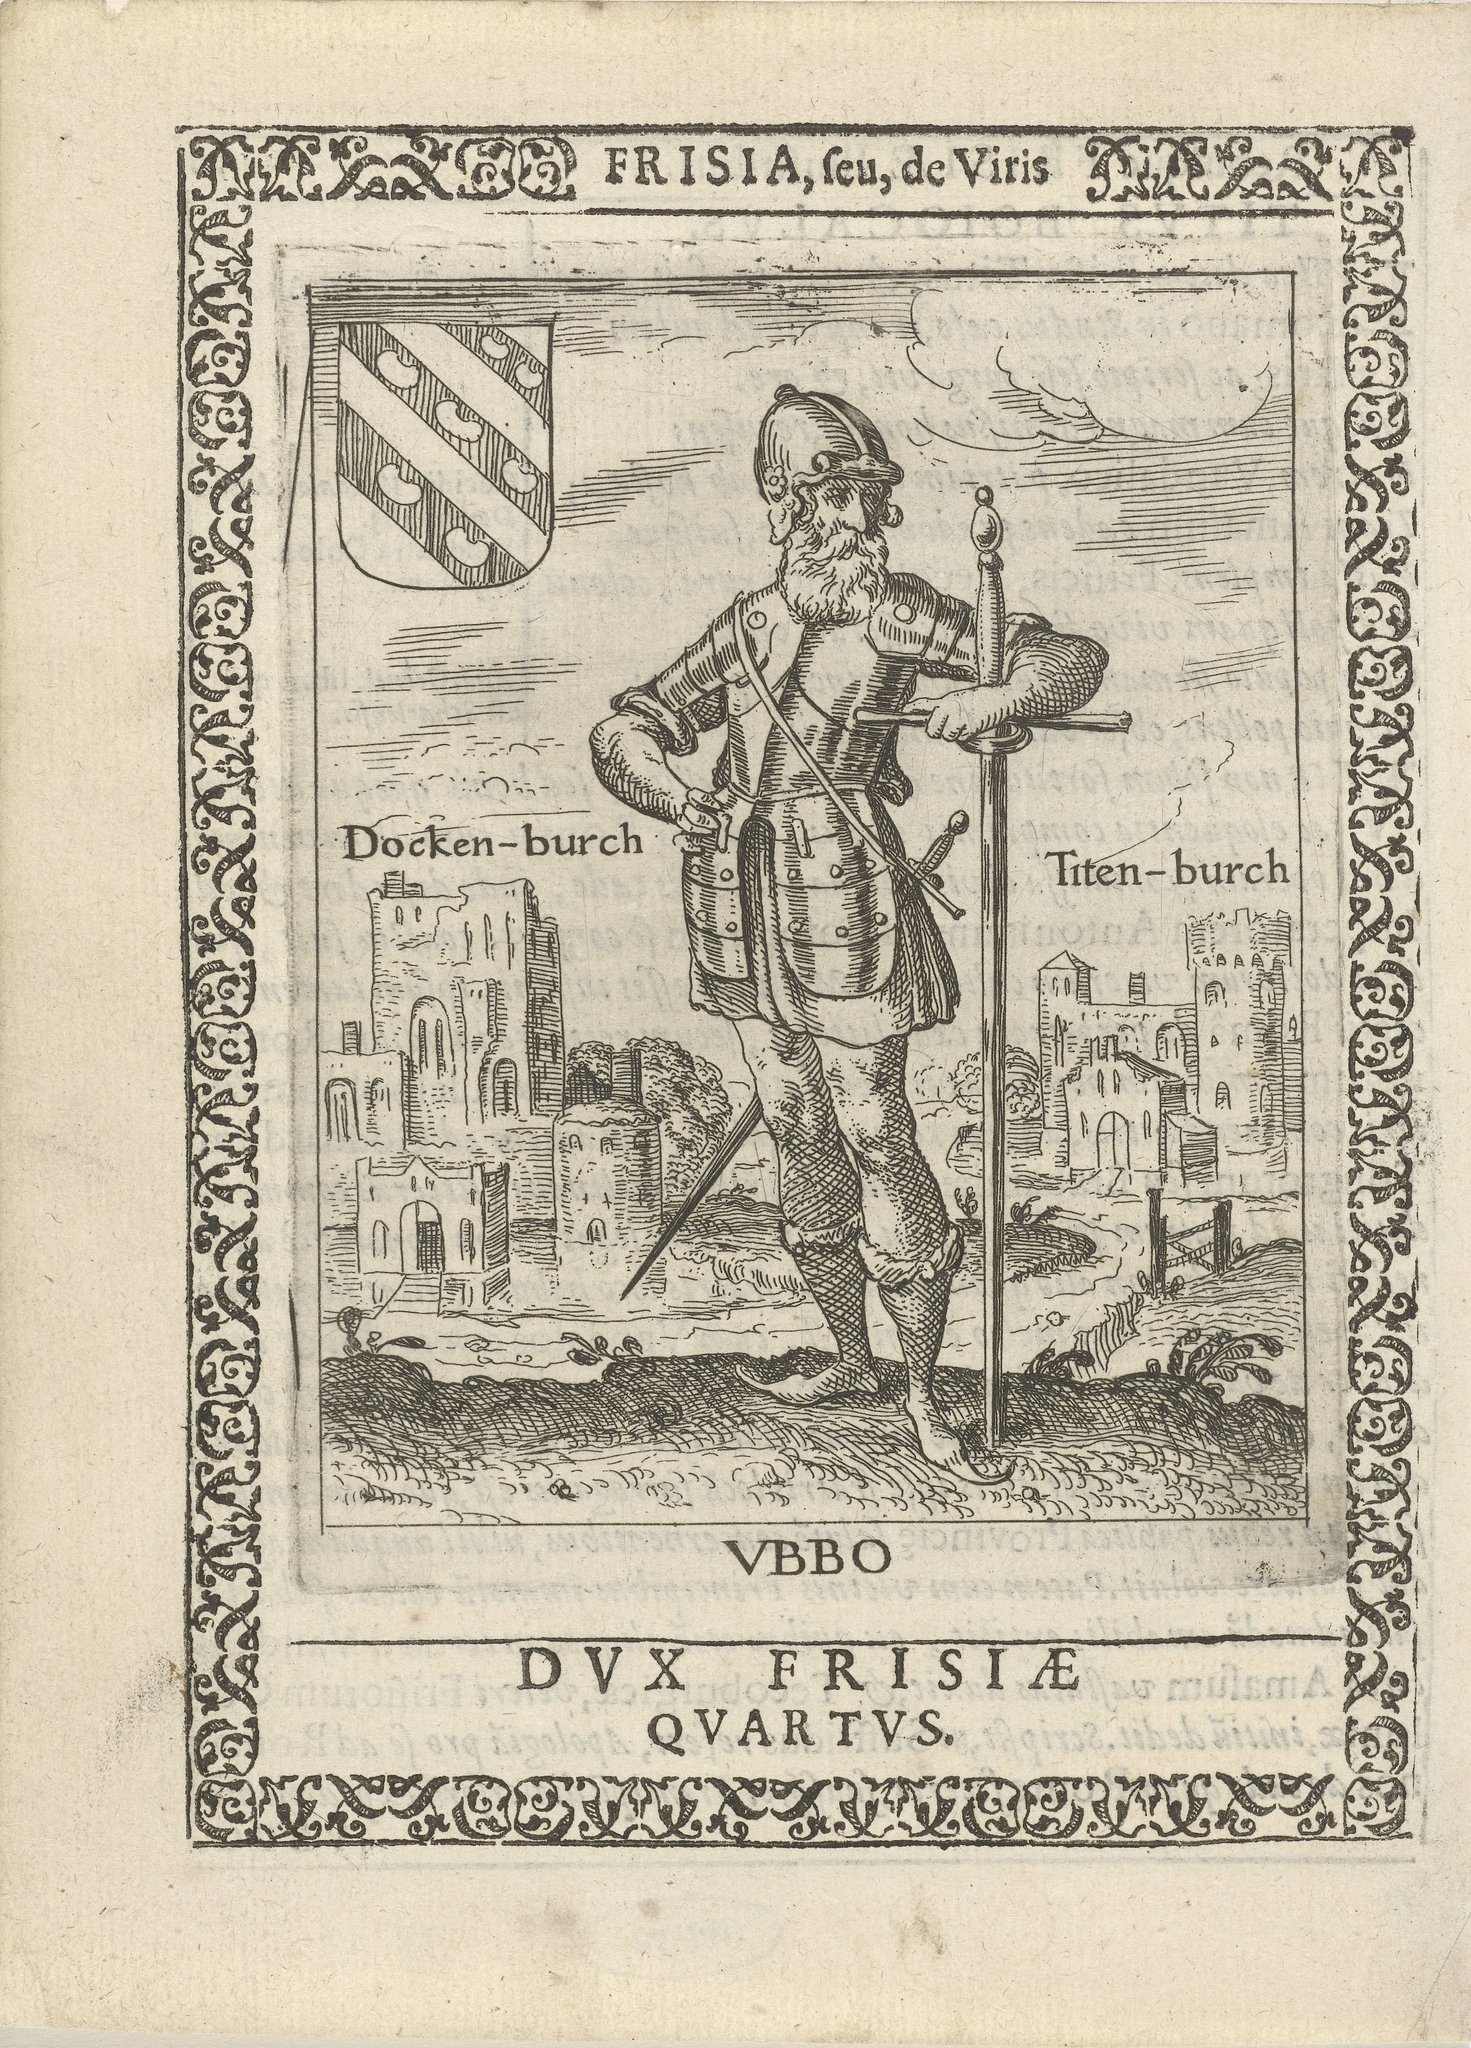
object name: print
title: Ubbo, vierde hertog der Friezen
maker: pieter feddes van harlingen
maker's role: painter, print maker, publisher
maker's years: 1586-1623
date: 1618-1620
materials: paper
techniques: etching, letterpress printing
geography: friesland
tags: ruler, sovereign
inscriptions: collector's mark: Lugt 2228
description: Ubbo, vierde hertog der Friezen. Staande ten voeten uit, leunend op een groot zwaard. Op de achtergrond Docken-burch (Dokkum) en Titen-burch (Tekelenburg). In een ornamentale omlijsting. Illustratie, met tekst op achterzijde, afkomstig uit het boek: Frisia seu de viris rebusque Frisiae illustribus libri duo.